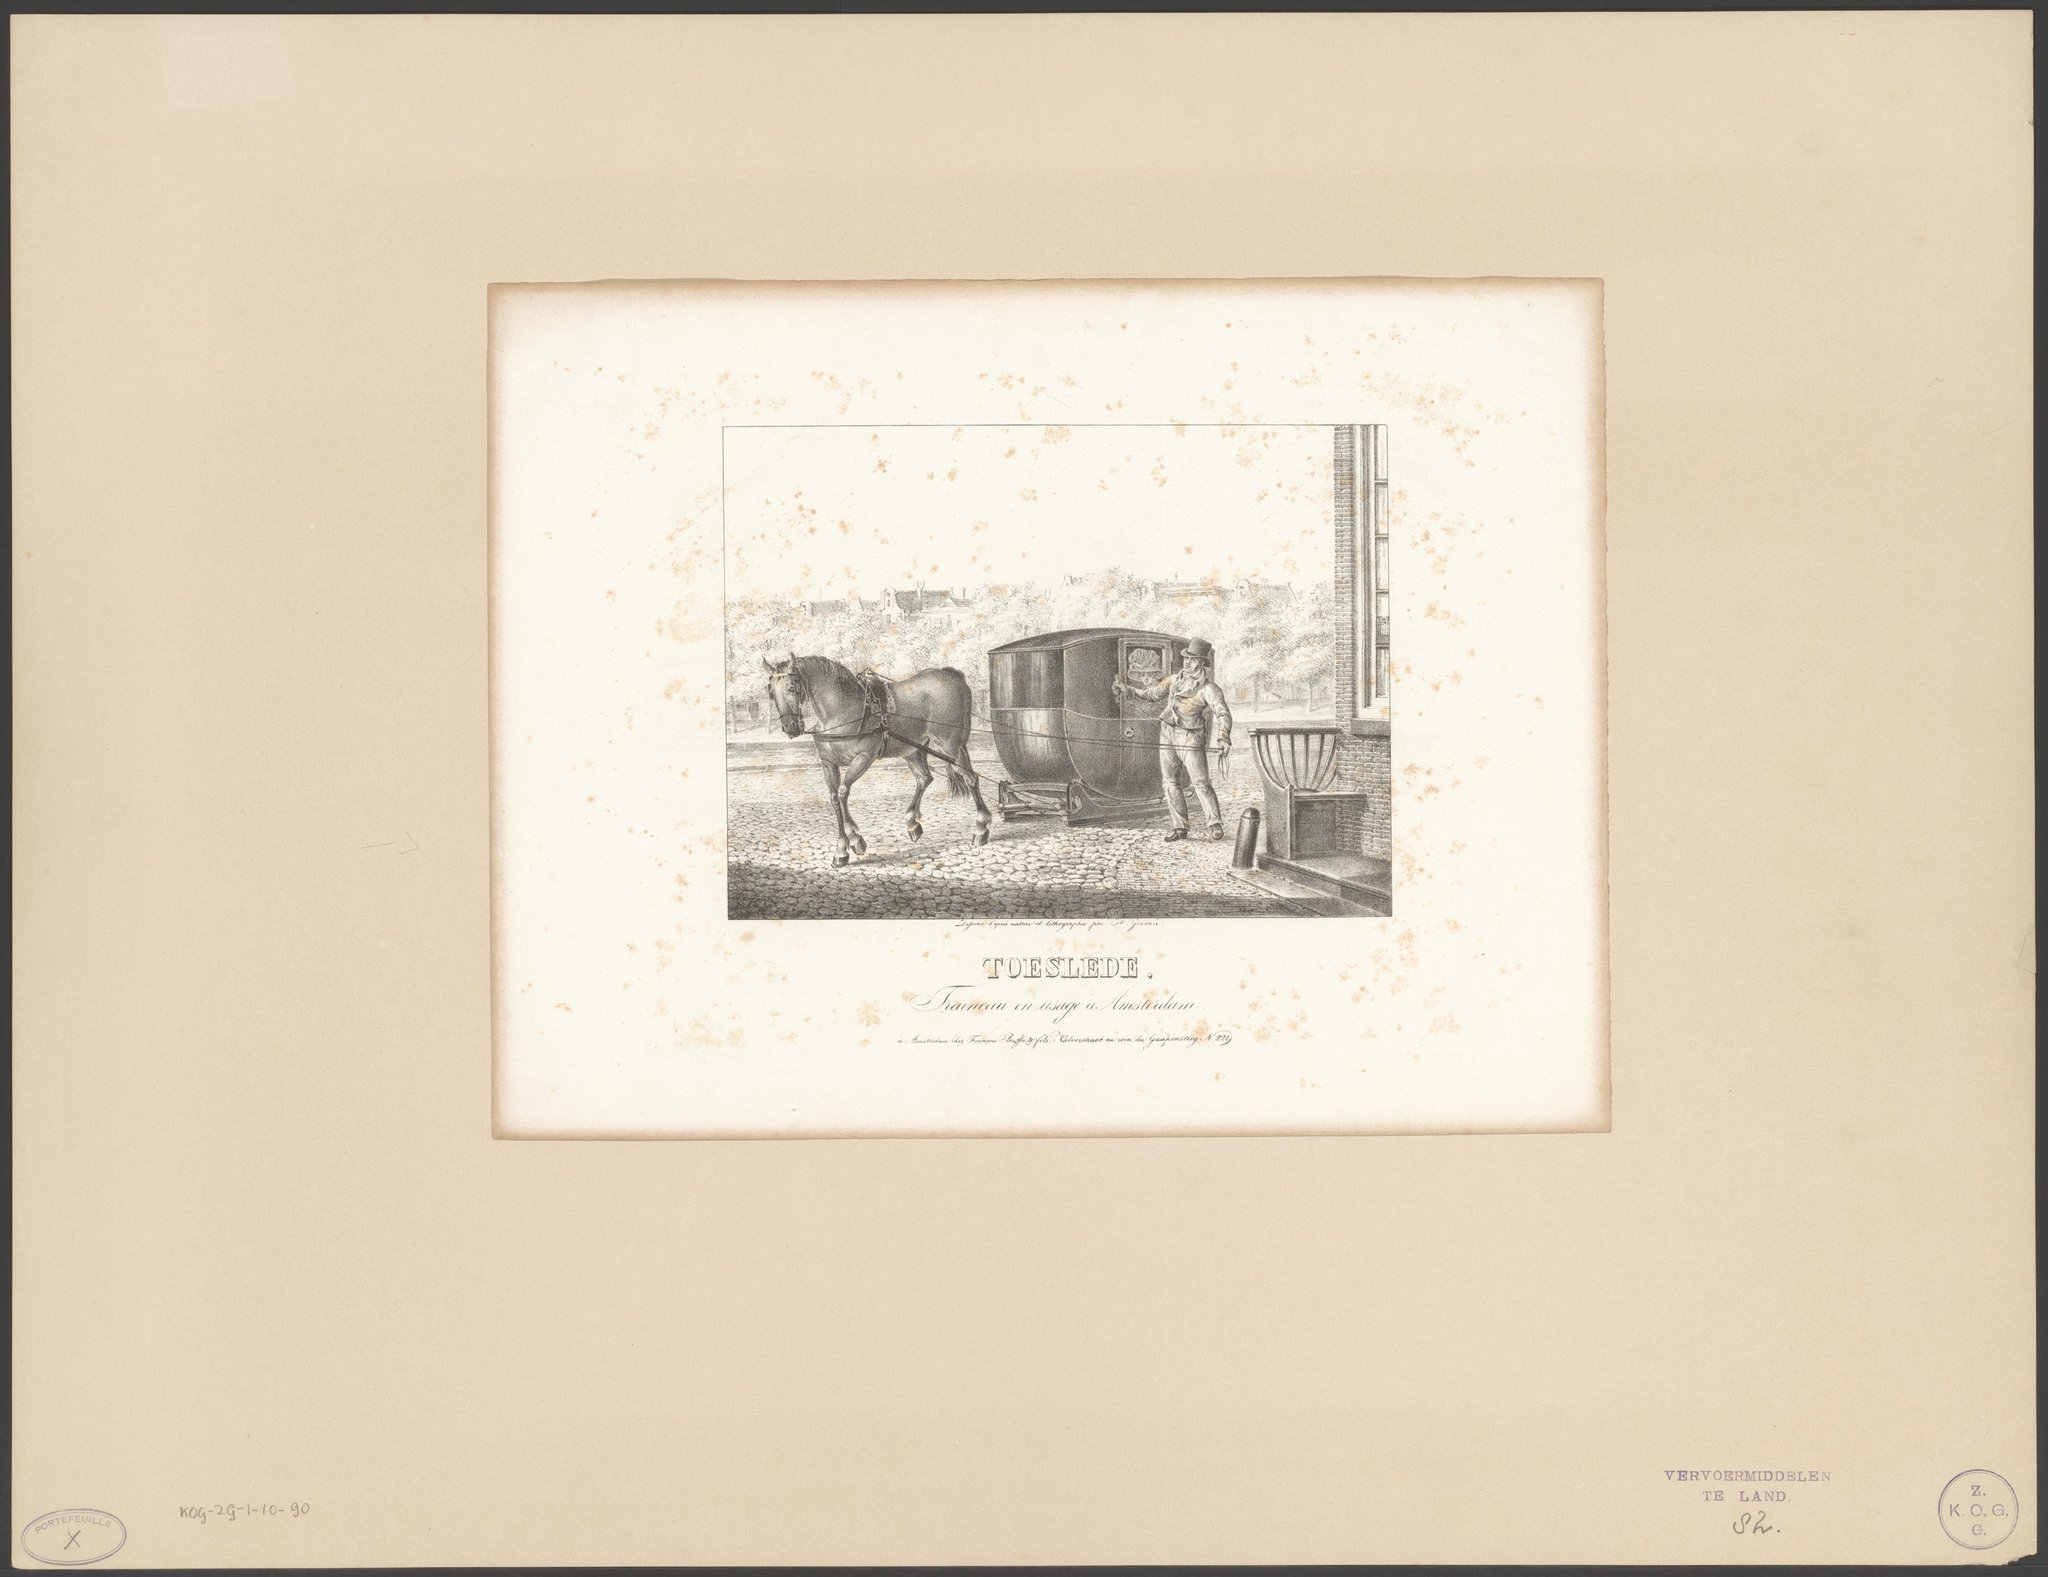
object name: print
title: Vrouw in een toeslede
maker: hendrik greeven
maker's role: painter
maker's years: 1787-1854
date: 1836-1854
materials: paper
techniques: lithograph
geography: amsterdam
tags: animal-drawn sledge (dutch: 'toeslede')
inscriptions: stamp, collector's mark: Lugt 1641, stamp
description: Vrouw in een toeslede. Voor de toeslede of sleepkoets staat een paard. Een man staat naast de slede en houdt de teugels van het paard vast. In de koets zit een dame. De koetsier staat naast de deur. Onderwerpsrubrieken binnen de Atlas Zeden en Gewoonten: Vervoermiddelen te land en te water, Vervoermiddelen te land, Toesleden.